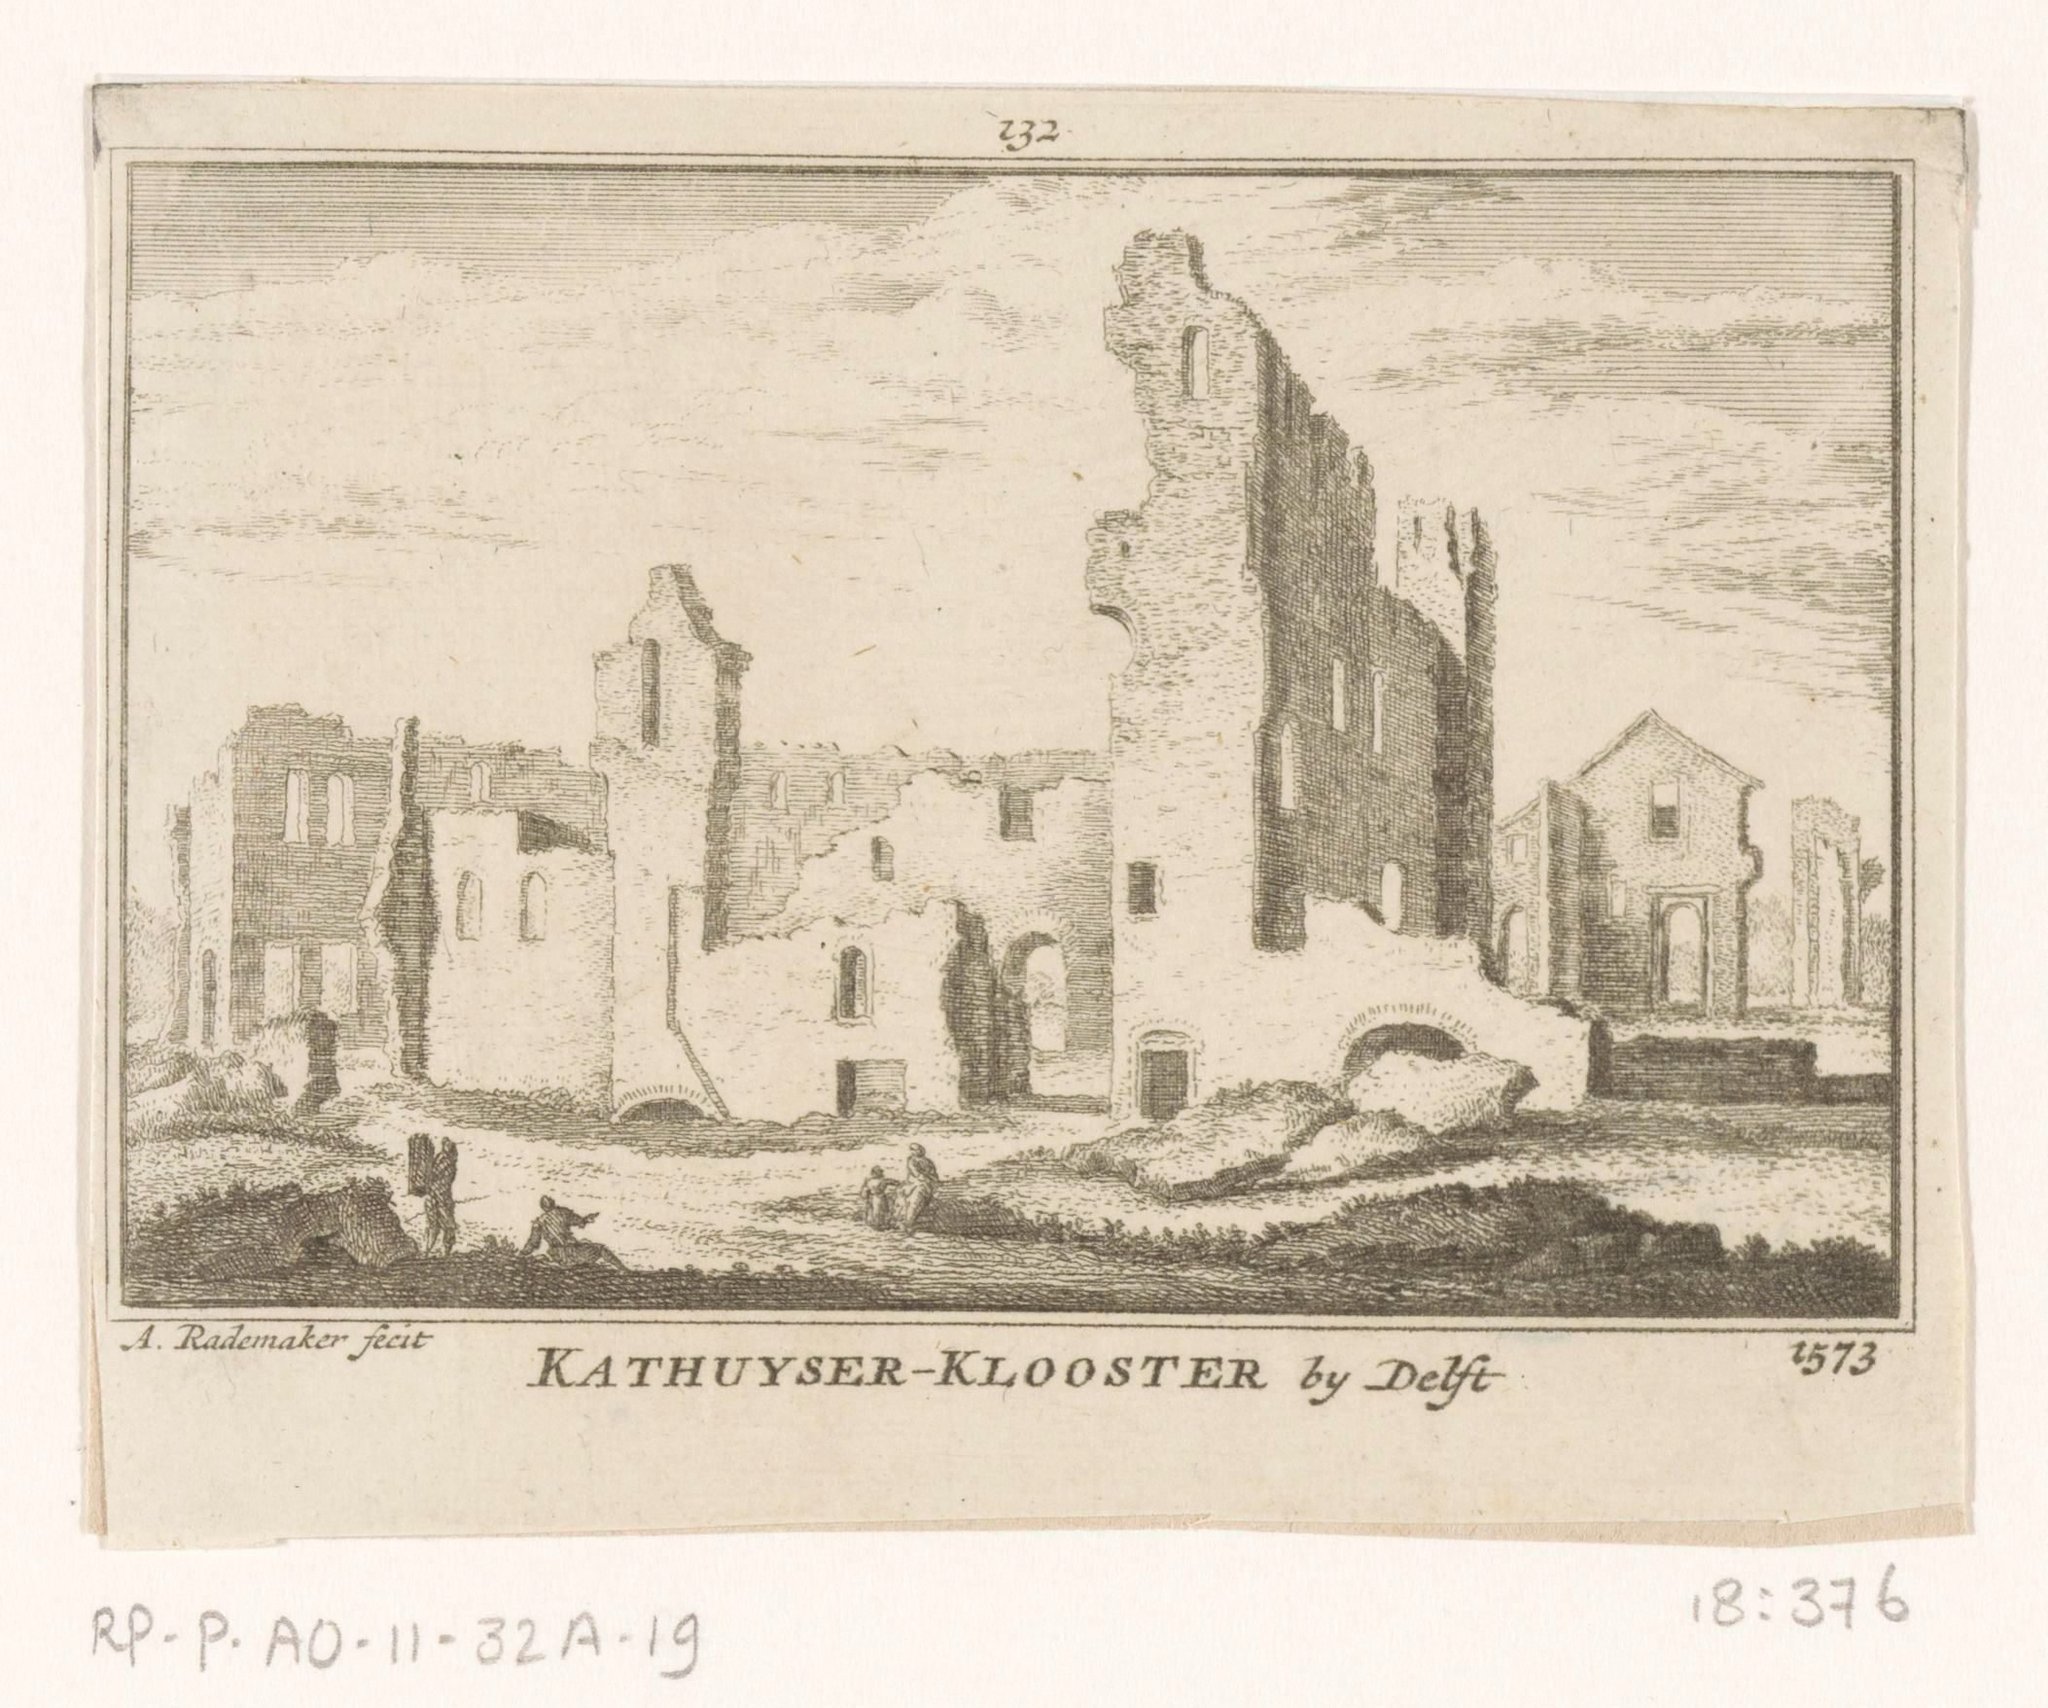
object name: print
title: Kathuyser-Klooster by Delft 1573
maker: abraham rademaker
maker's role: draughtsman, print maker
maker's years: 1676-1735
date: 1725-1803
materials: paper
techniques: engraving, etching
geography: amsterdam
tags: ruin of church, monastery, etc.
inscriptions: collector's mark: Lugt 2228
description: Prent ook gebruikt in: Rademaker, Abraham. Kabinet van Nederlandsche outheden en gezichten: vervat in 300 konstplaaten (…). 2 delen. Amsterdam: Willem Barents, 1725, dl. 1, ill. 132. Na 1725 is deze prent nog in verschillende heruitgaven verschenen, uitgegeven in 1727-1733, 1770-1771 en 1792-1803. Uit welke uitgave het huidige exemplaar precies komt is niet na te gaan.